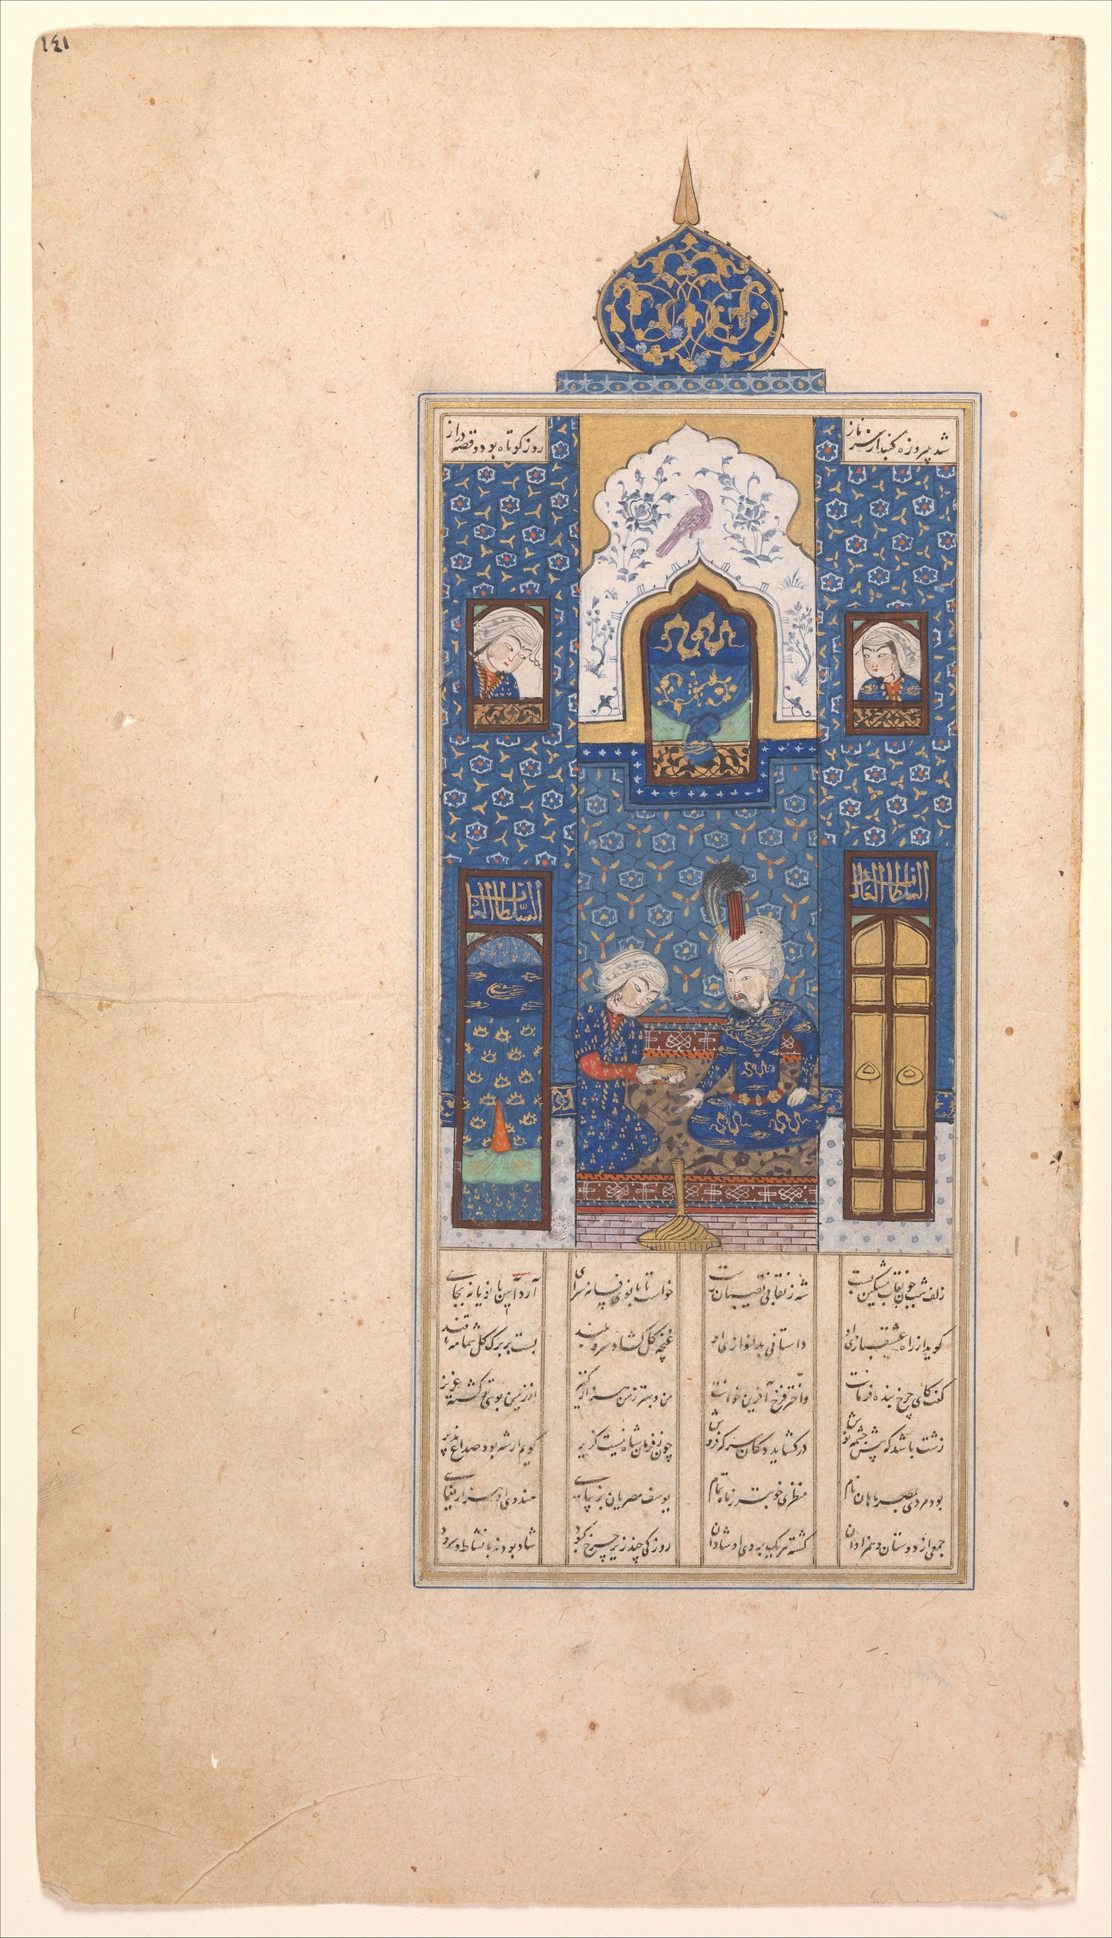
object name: folio from an illustrated manuscript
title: "Bahram Gur in the Blue Pavilion", Folio from a Khamsa (Quintet) of Nizami of Ganja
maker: nizami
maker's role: author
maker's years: 1141-1209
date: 1501-1533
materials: gold, ink, paper, watercolor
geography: iran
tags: buildings,kings,women